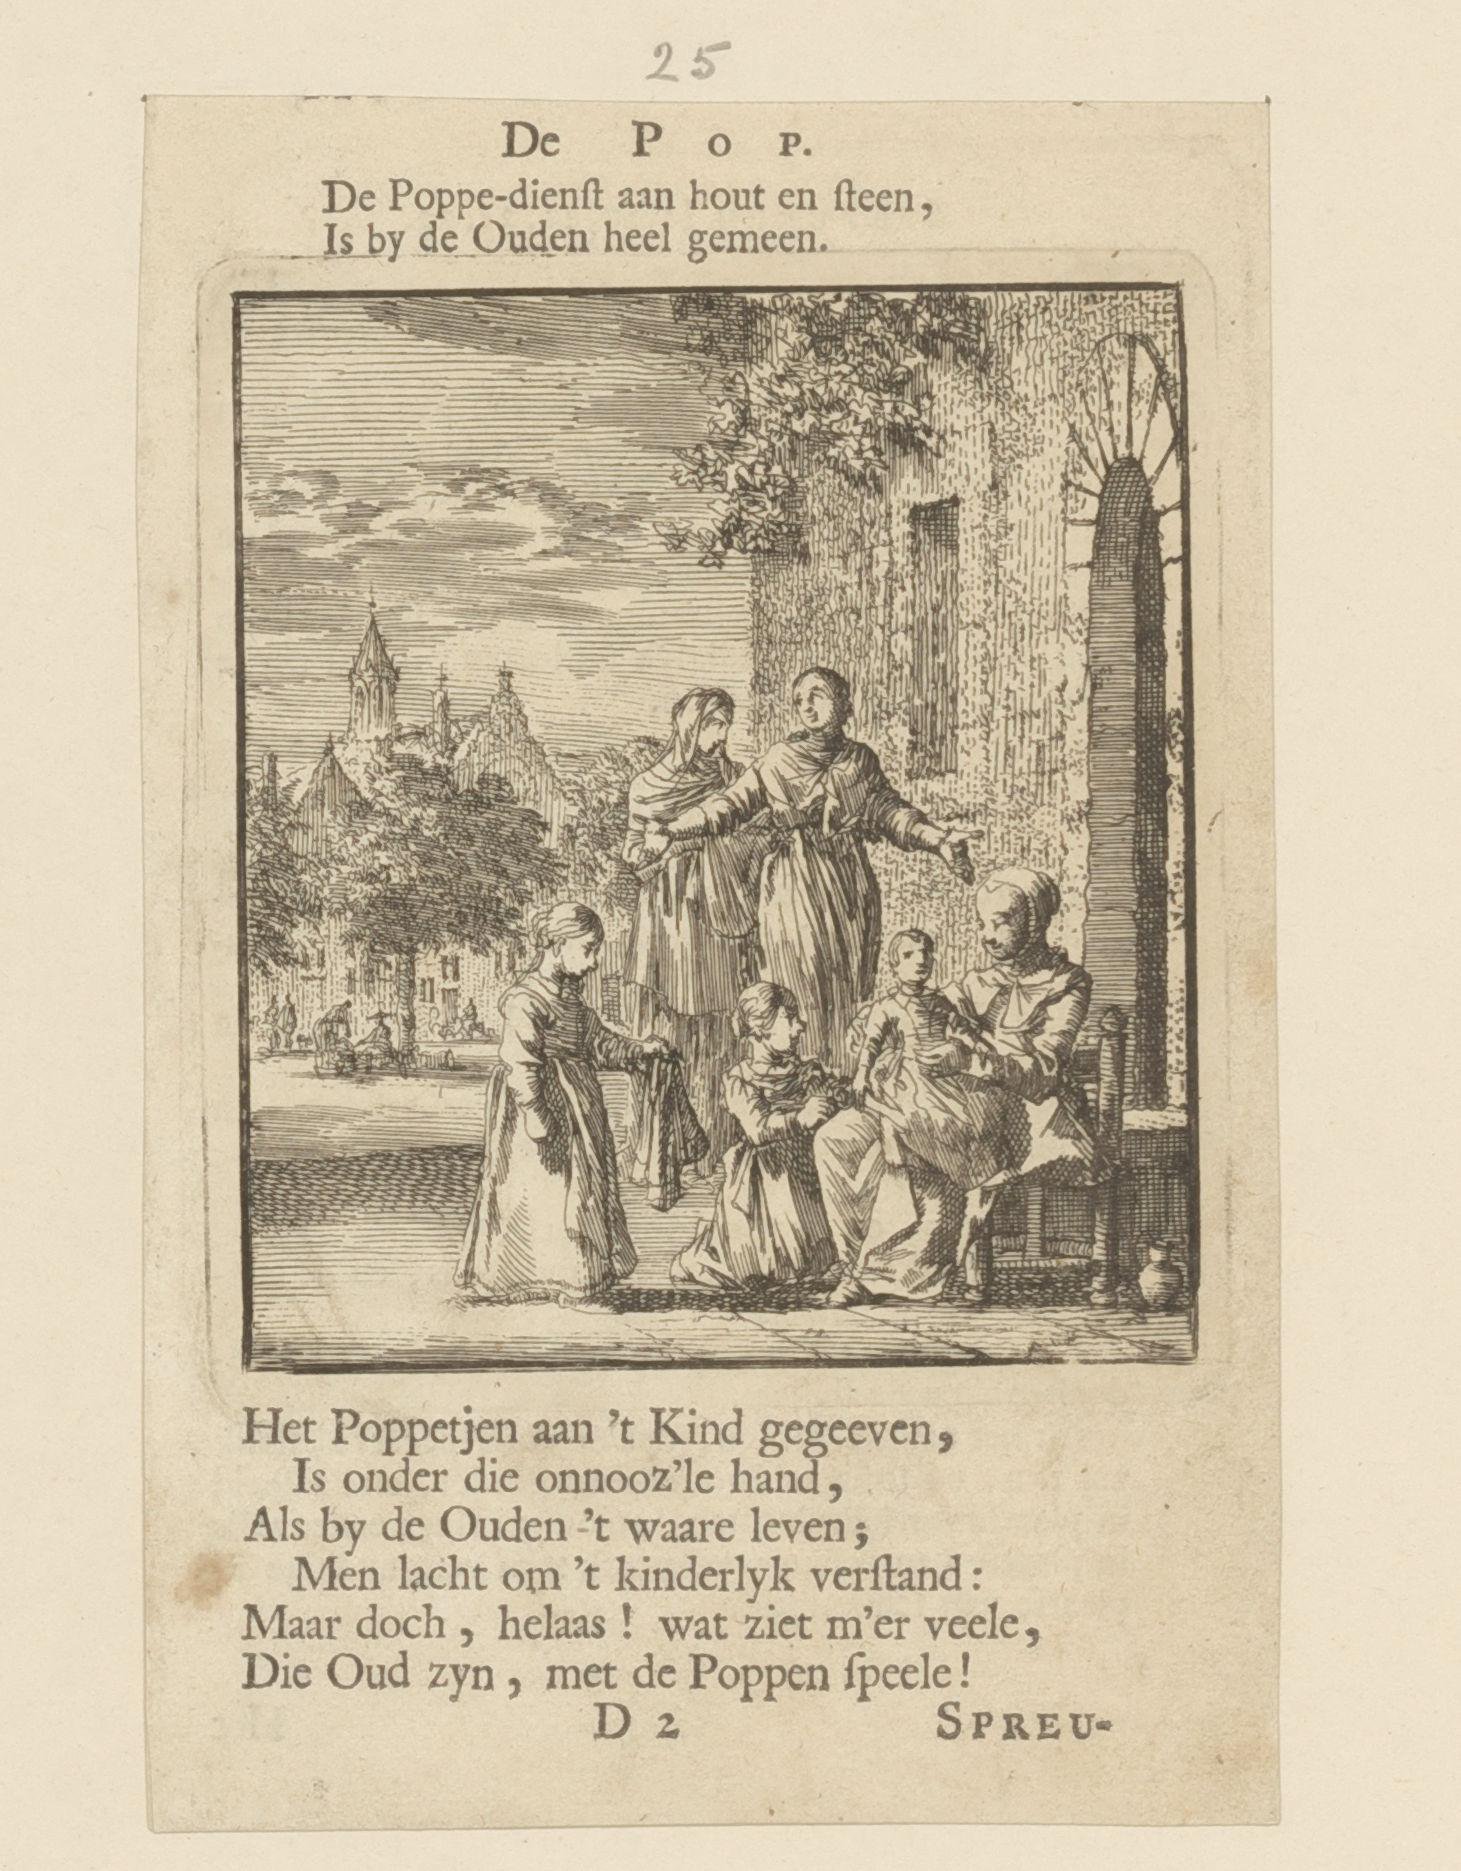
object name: print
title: De Pop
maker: jan luyken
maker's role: draughtsman, print maker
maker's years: 1649-1712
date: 1712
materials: paper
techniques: etching, letterpress printing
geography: amsterdam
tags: (playing with) dolls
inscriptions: collector's mark: Lugt 1641, stamp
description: Onderwerpsrubrieken binnen de Atlas Zeden en Gewoonten: Zeden en Gewoonten in Engeren Zin, Des menschen beging, midden en einde, Kinderleven – Kinderspel en Kinderprenten.